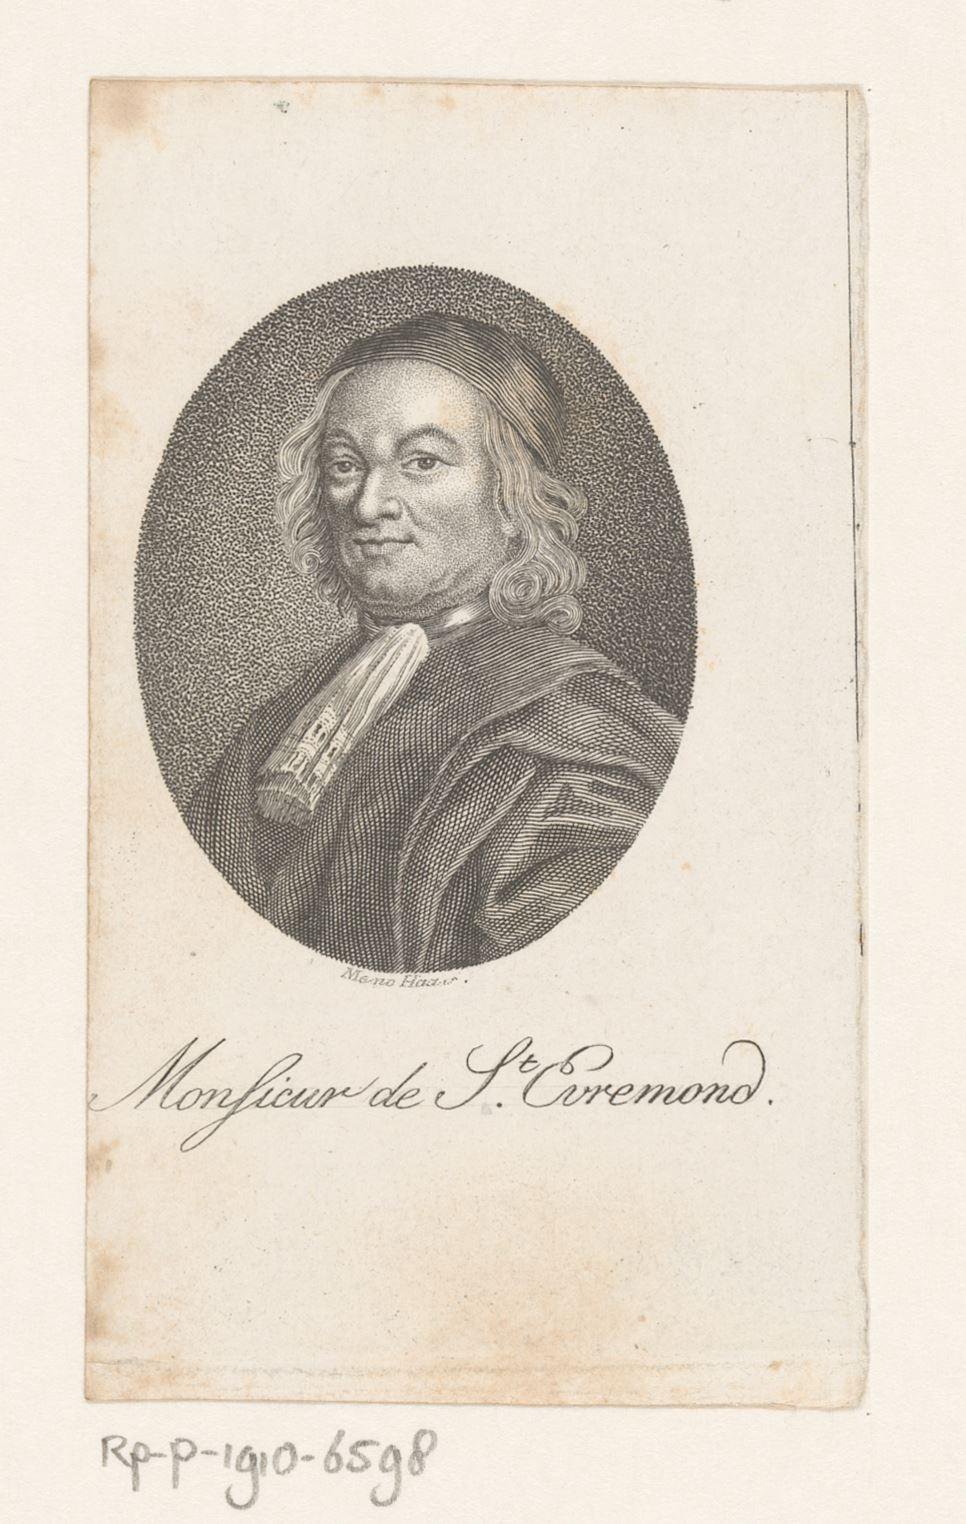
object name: print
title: Portret van Charles de Saint-Évremond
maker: meno haas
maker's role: print maker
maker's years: 1752-1833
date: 1762-1833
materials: paper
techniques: engraving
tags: historical persons, portrait of a writer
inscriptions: collector's mark: Lugt 2228